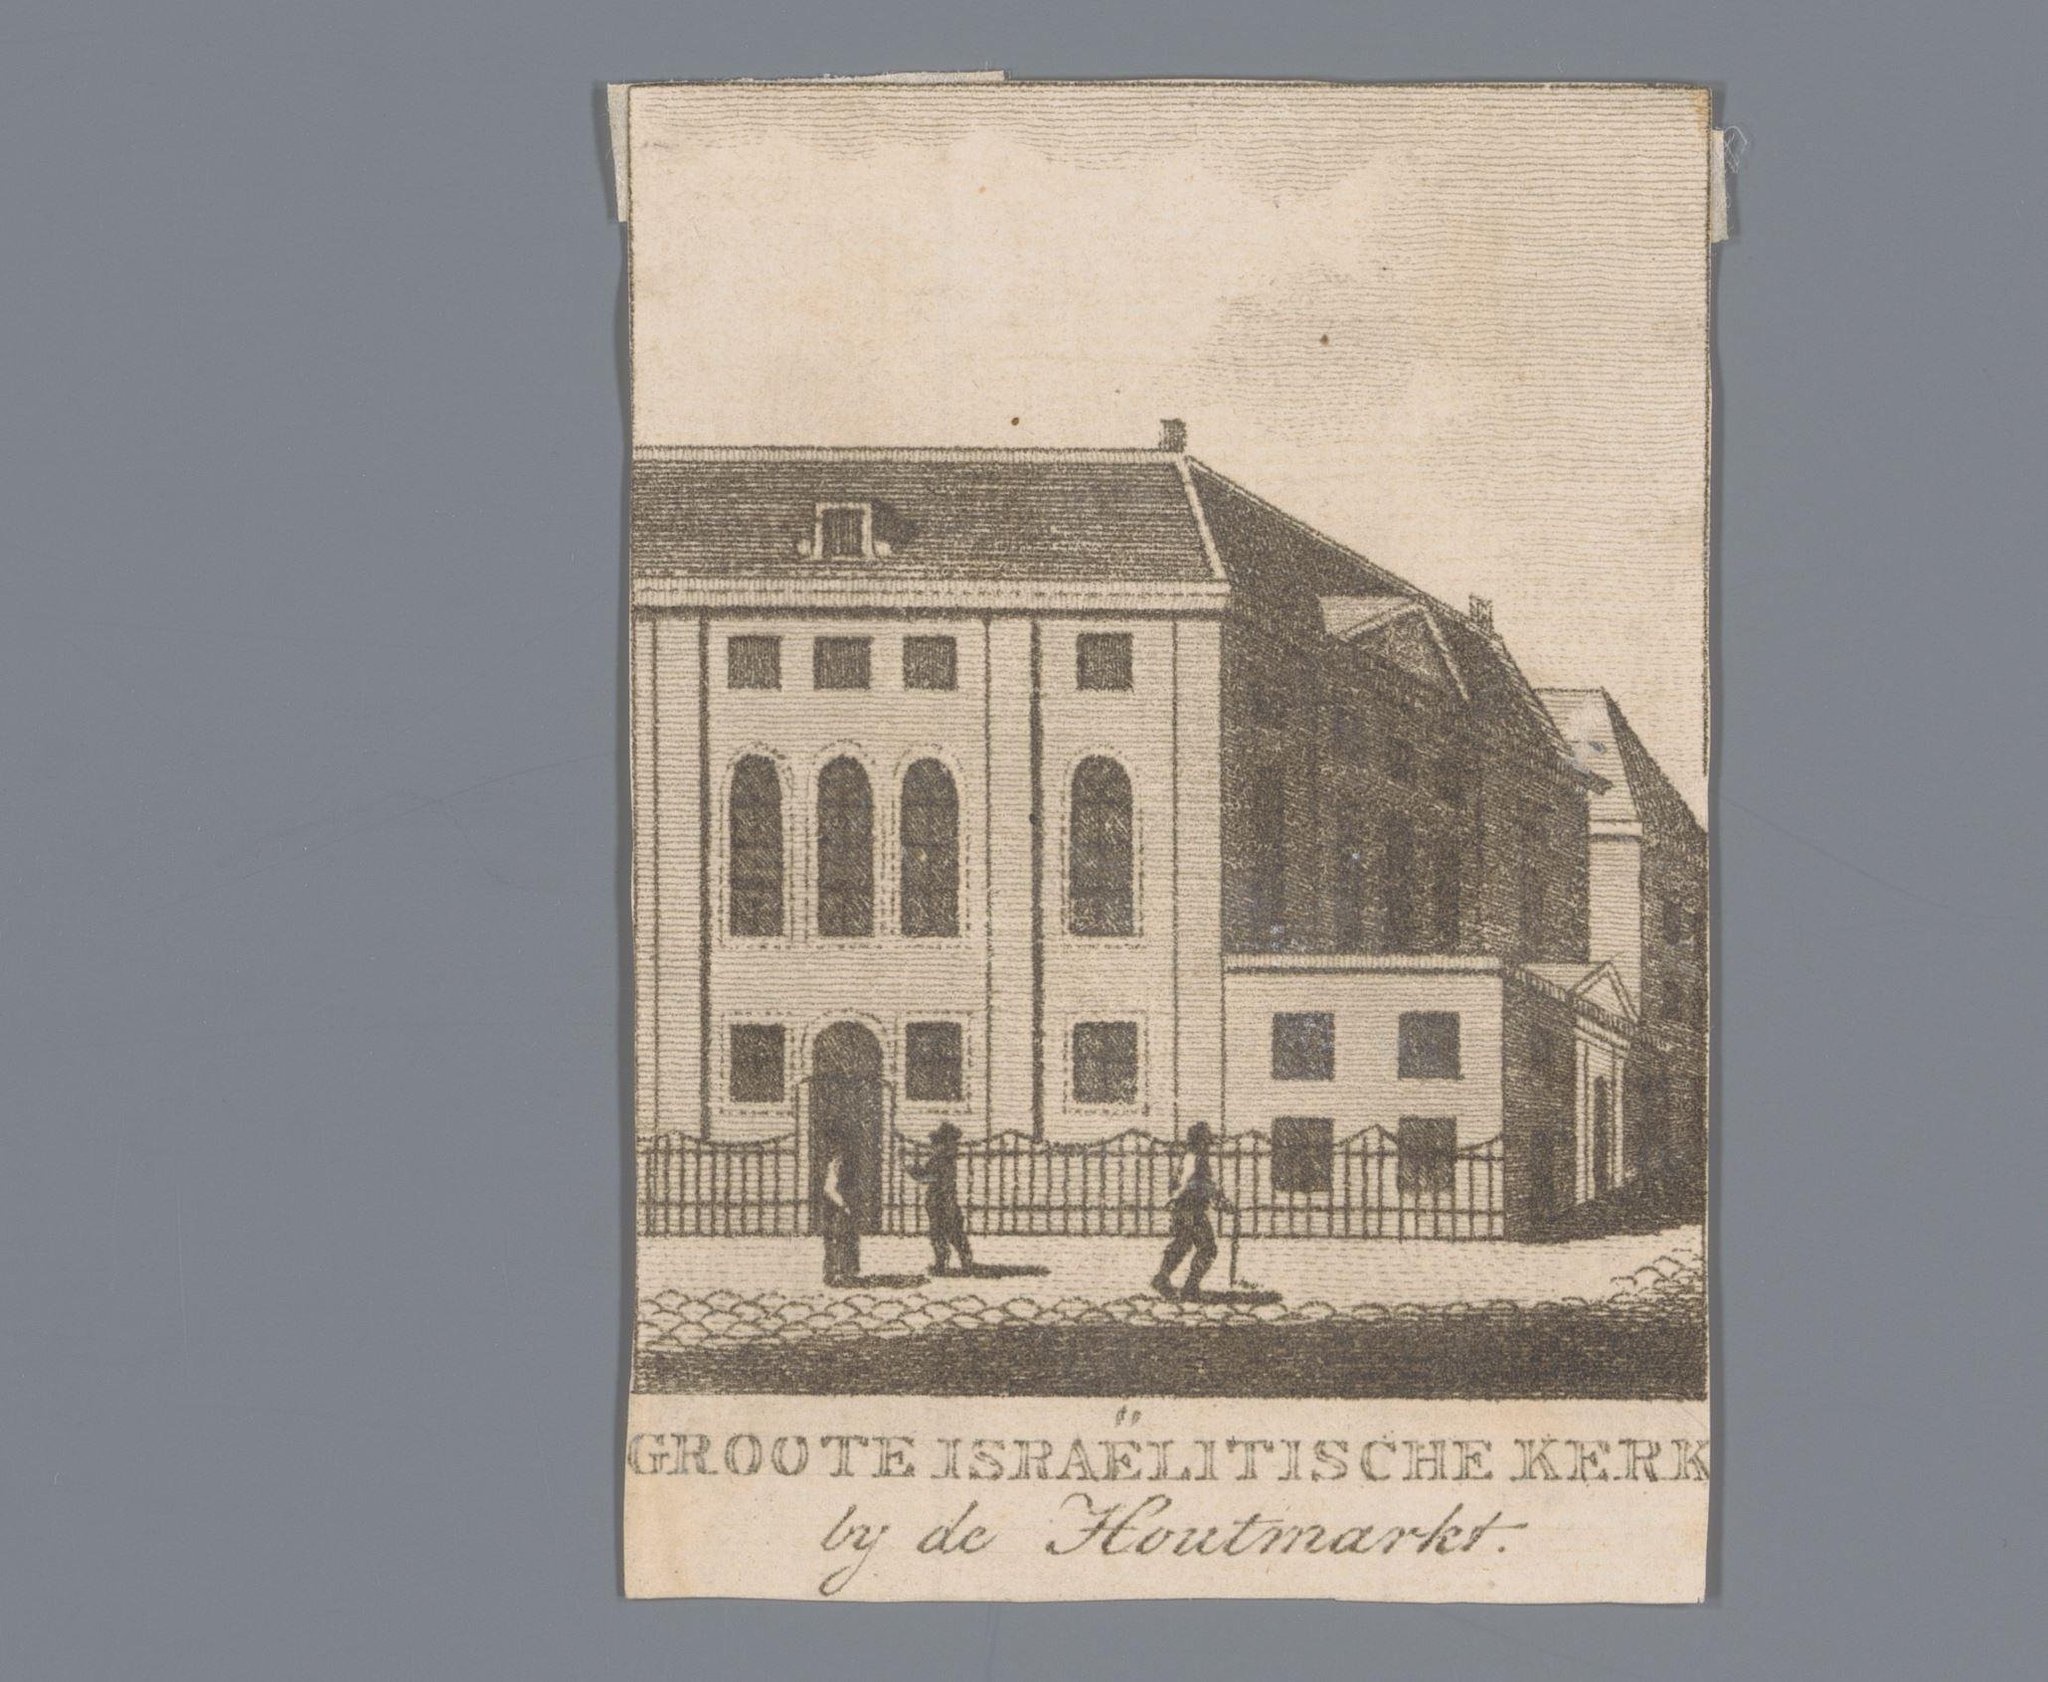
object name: print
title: Gezicht op de Grote Synagoge te Amsterdam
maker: Anonymous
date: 1800-1840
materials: paper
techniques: etching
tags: the synagogue (as building and place of worship ~ jewish religion)